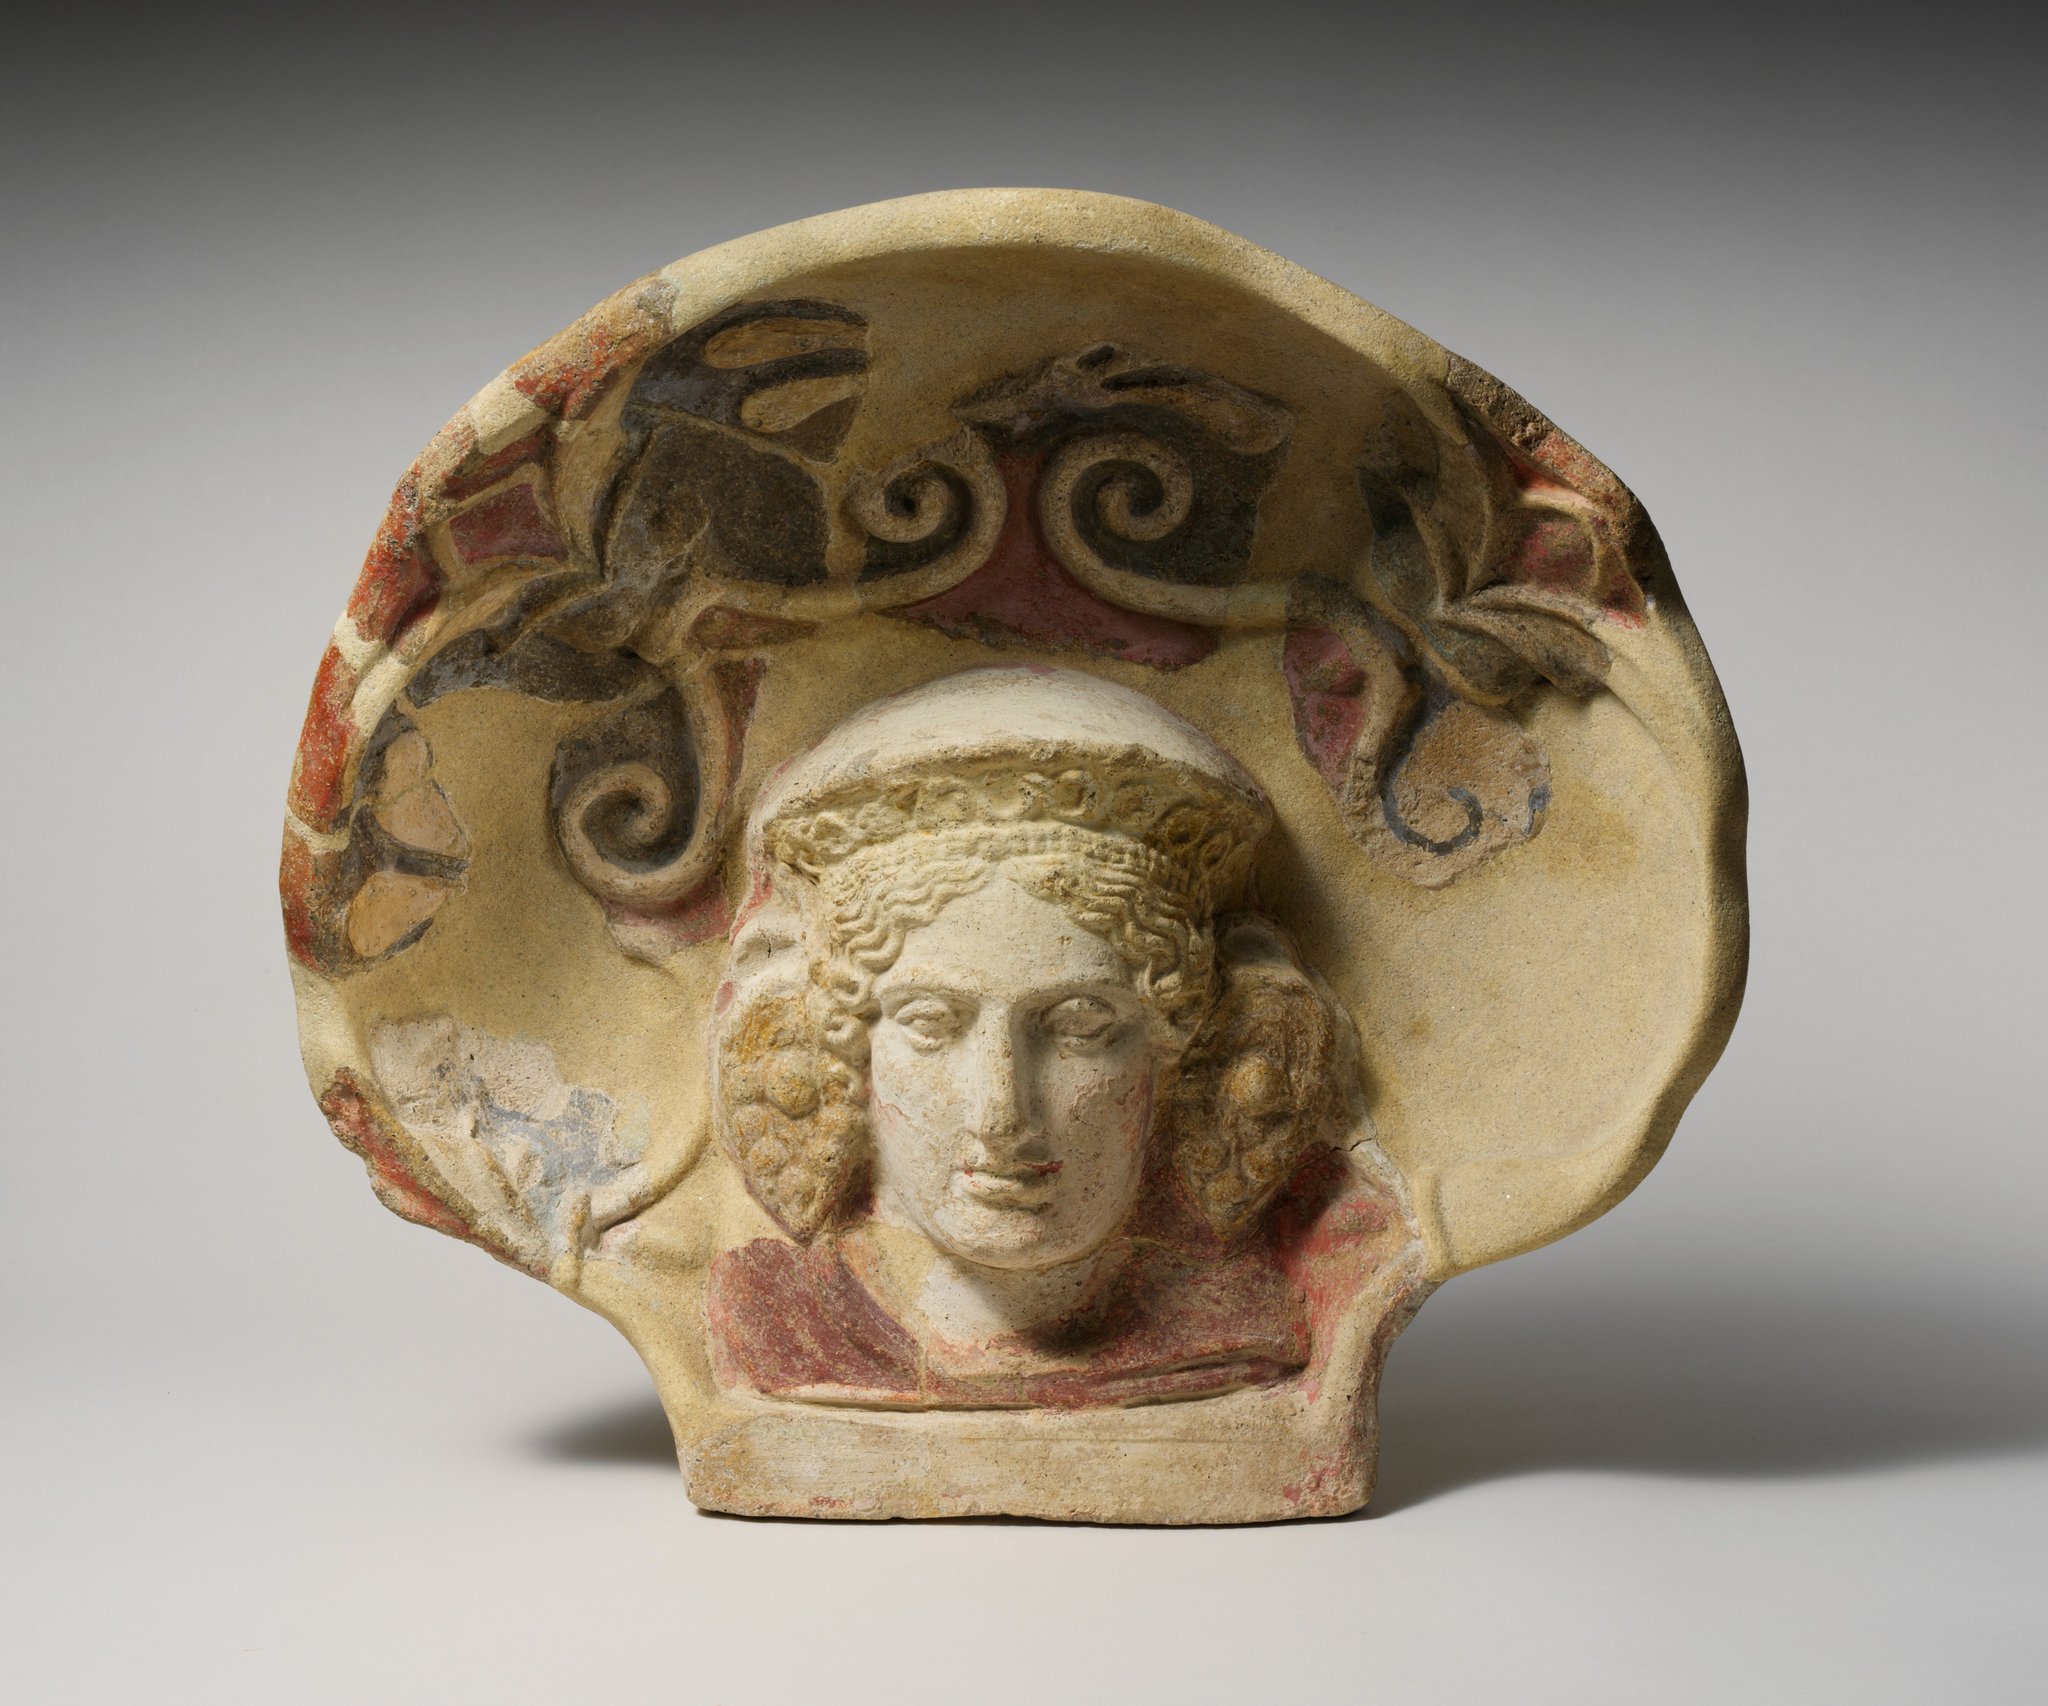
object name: antefix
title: Terracotta antefix (roof tile) with head of a maenad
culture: etruscan, cerveteri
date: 334-301 BCE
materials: terracotta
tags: maenads